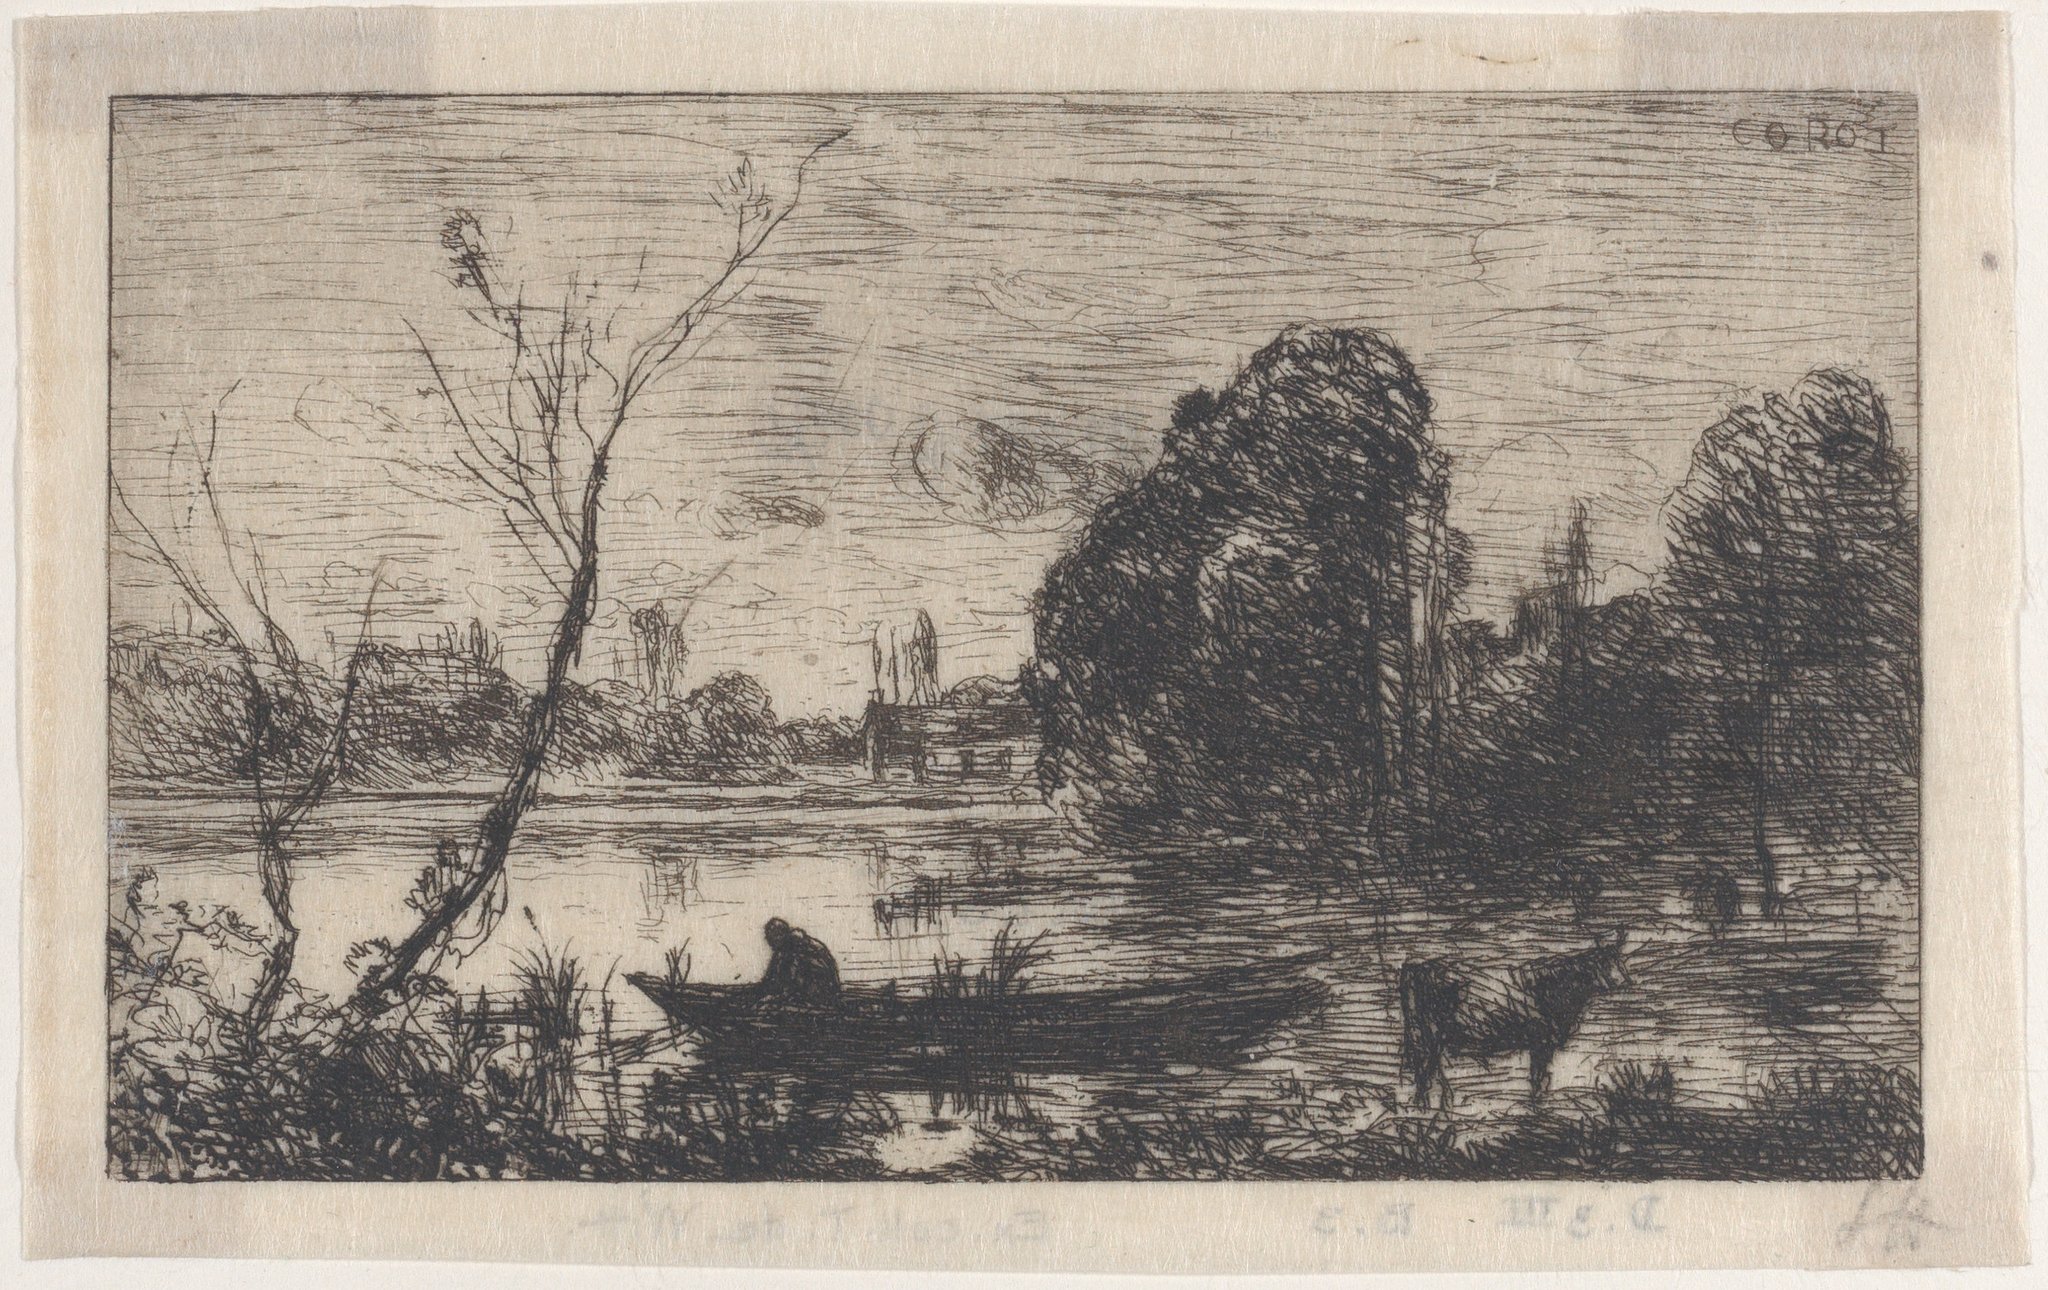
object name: print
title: Ville d'Avray: Boatman on a Pond (Evening Effect)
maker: jean-baptiste-camille corot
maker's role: artist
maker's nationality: french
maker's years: 1796-1875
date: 1862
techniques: etching